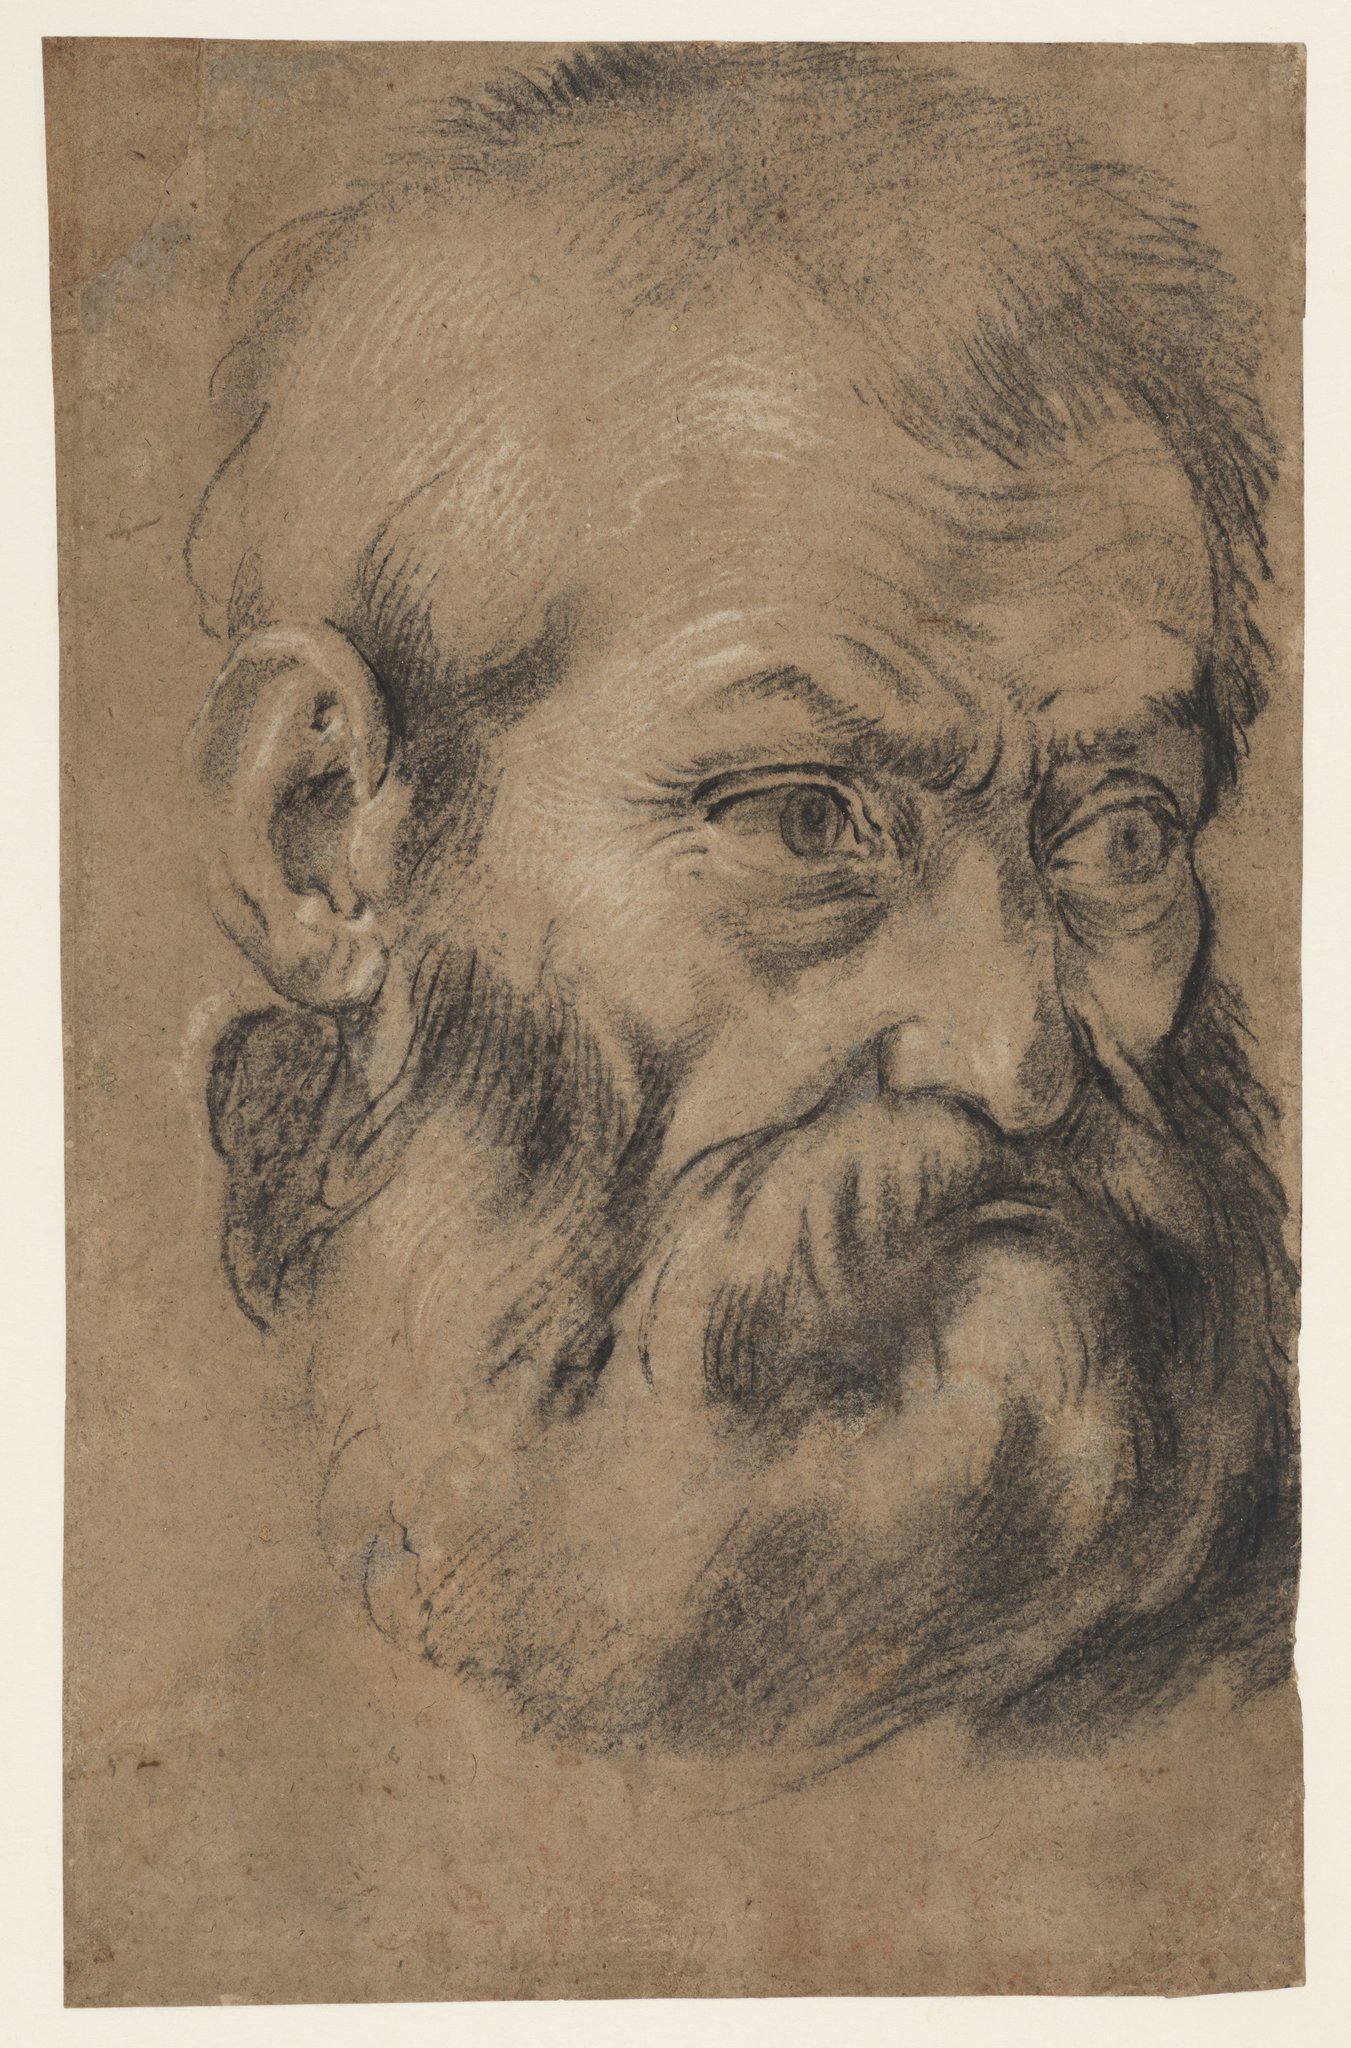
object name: drawing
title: Head of beared man (recto), Study of an apostle (verso)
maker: giacomo cavedone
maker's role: artist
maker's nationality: italian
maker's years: 1577-1660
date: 1620-1660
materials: chalk, paper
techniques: highlighting